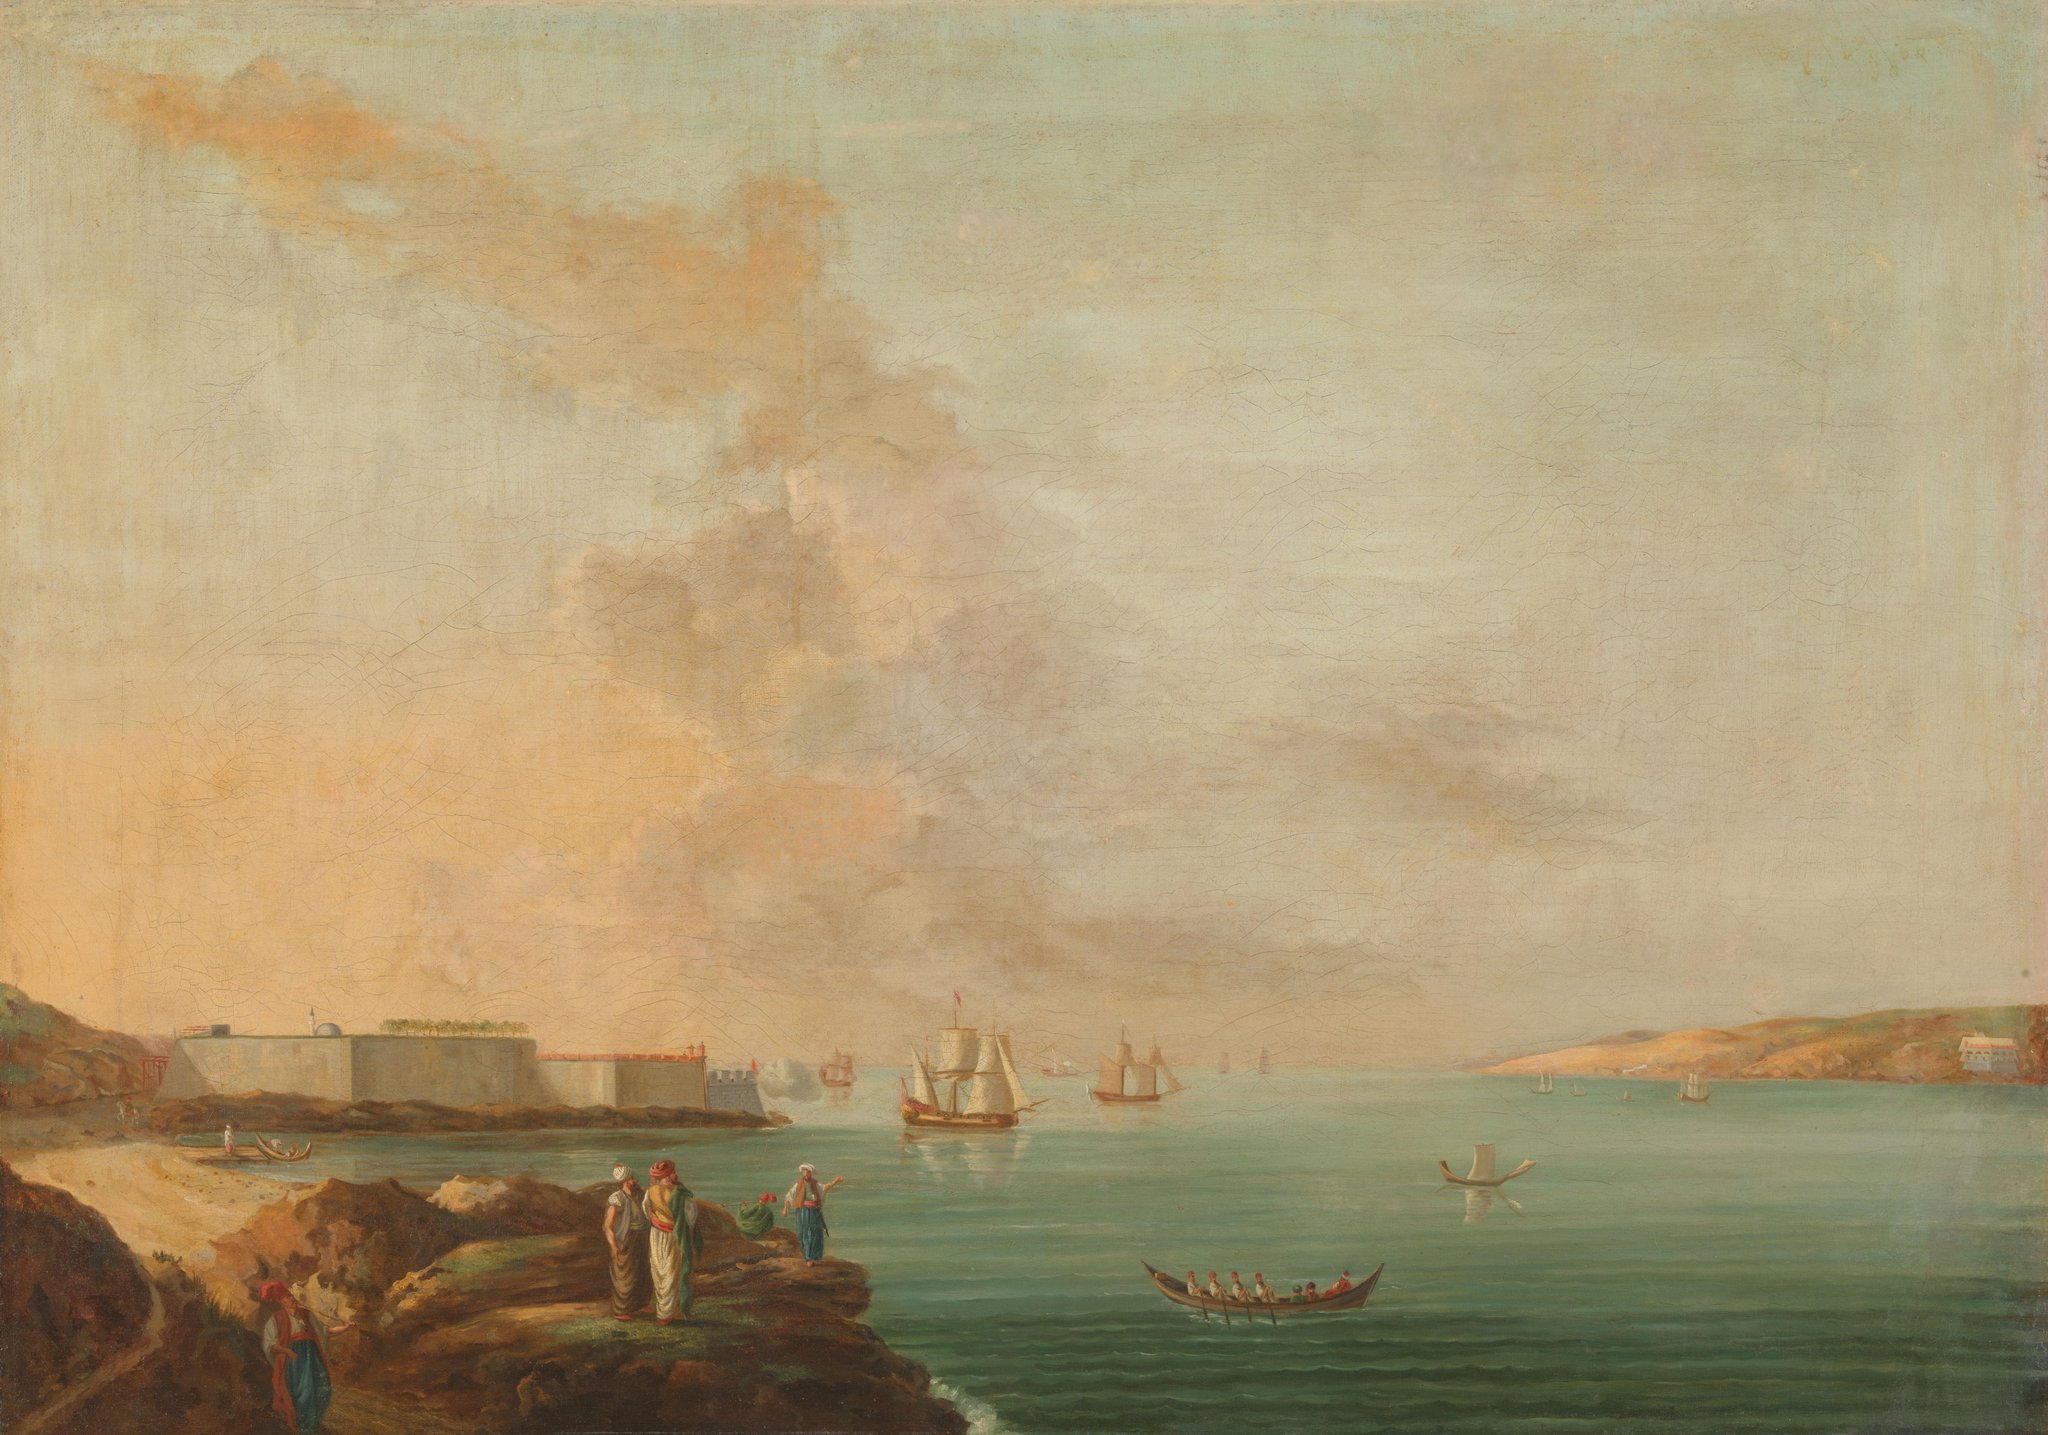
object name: painting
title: View of the Dardanelles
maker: antoine van der steen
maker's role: painter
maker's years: -1784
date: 1770-1780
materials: canvas, oil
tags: fortress, rocky coast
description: Gezicht op de Dardanellen, op het water enkele schepen, links wordt vanuit een fort een schot gelost.